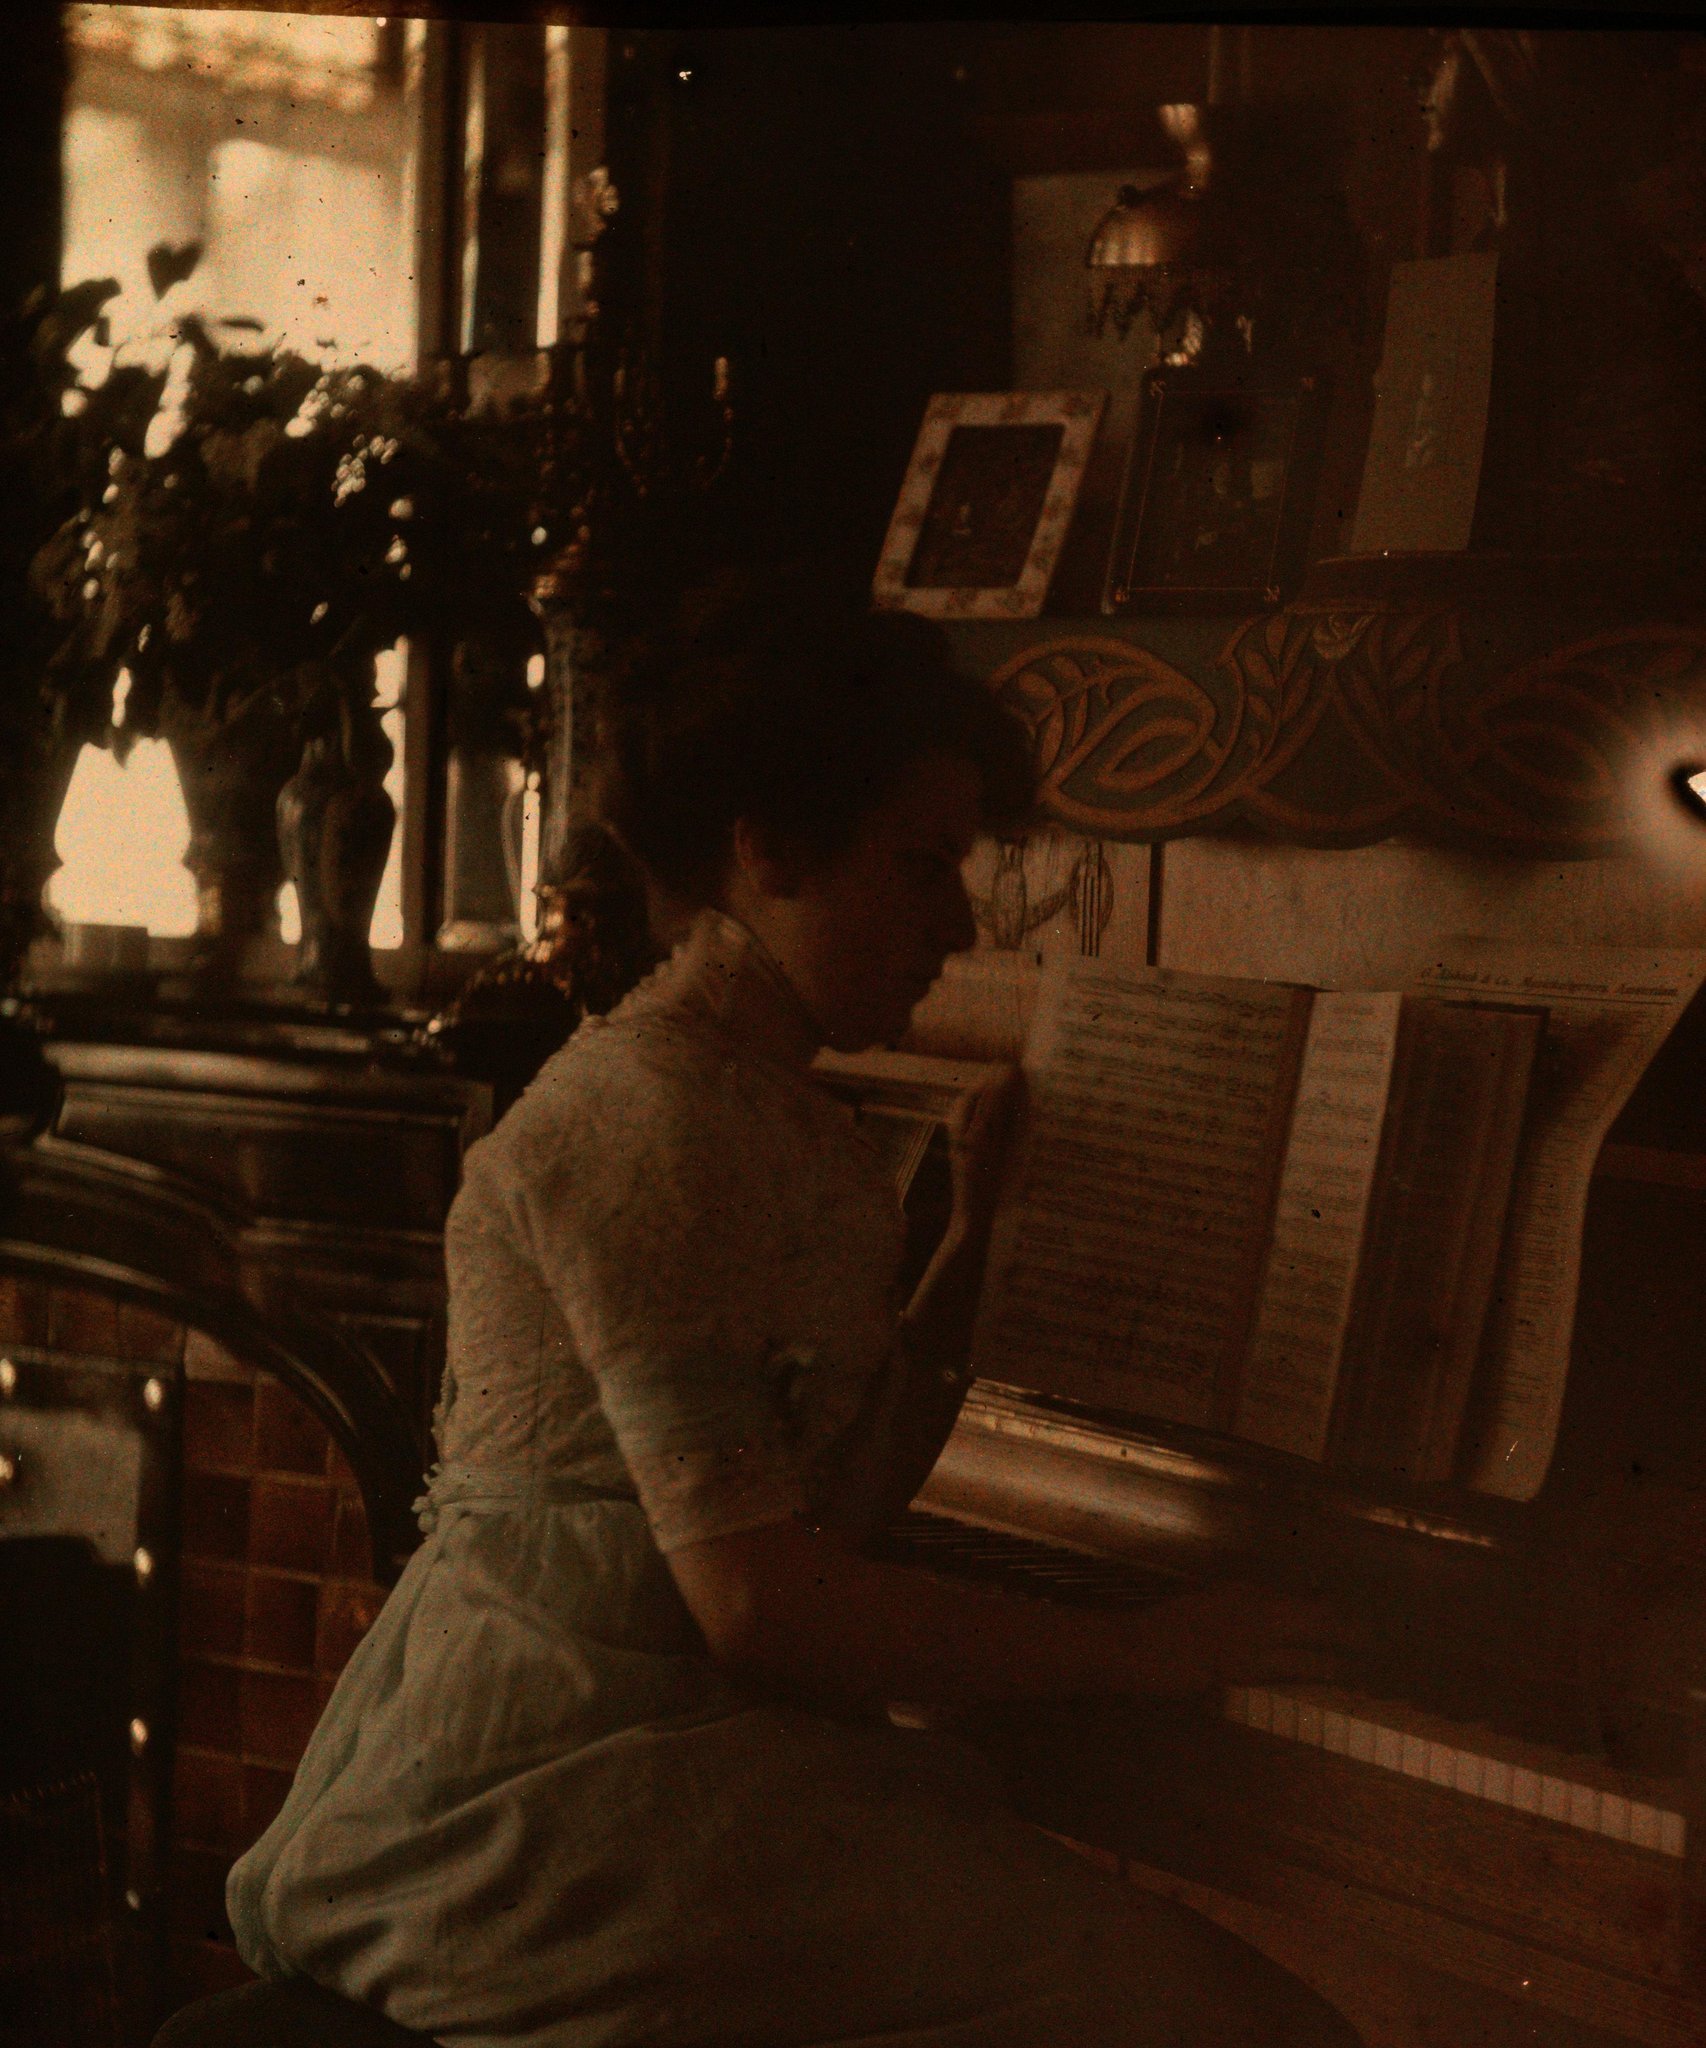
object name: photograph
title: Vrouw aan piano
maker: johannes hendrikus antonius maria lutz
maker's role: fotograaf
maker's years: -1916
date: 1907-1916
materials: glass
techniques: autochrome process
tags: pianoforte